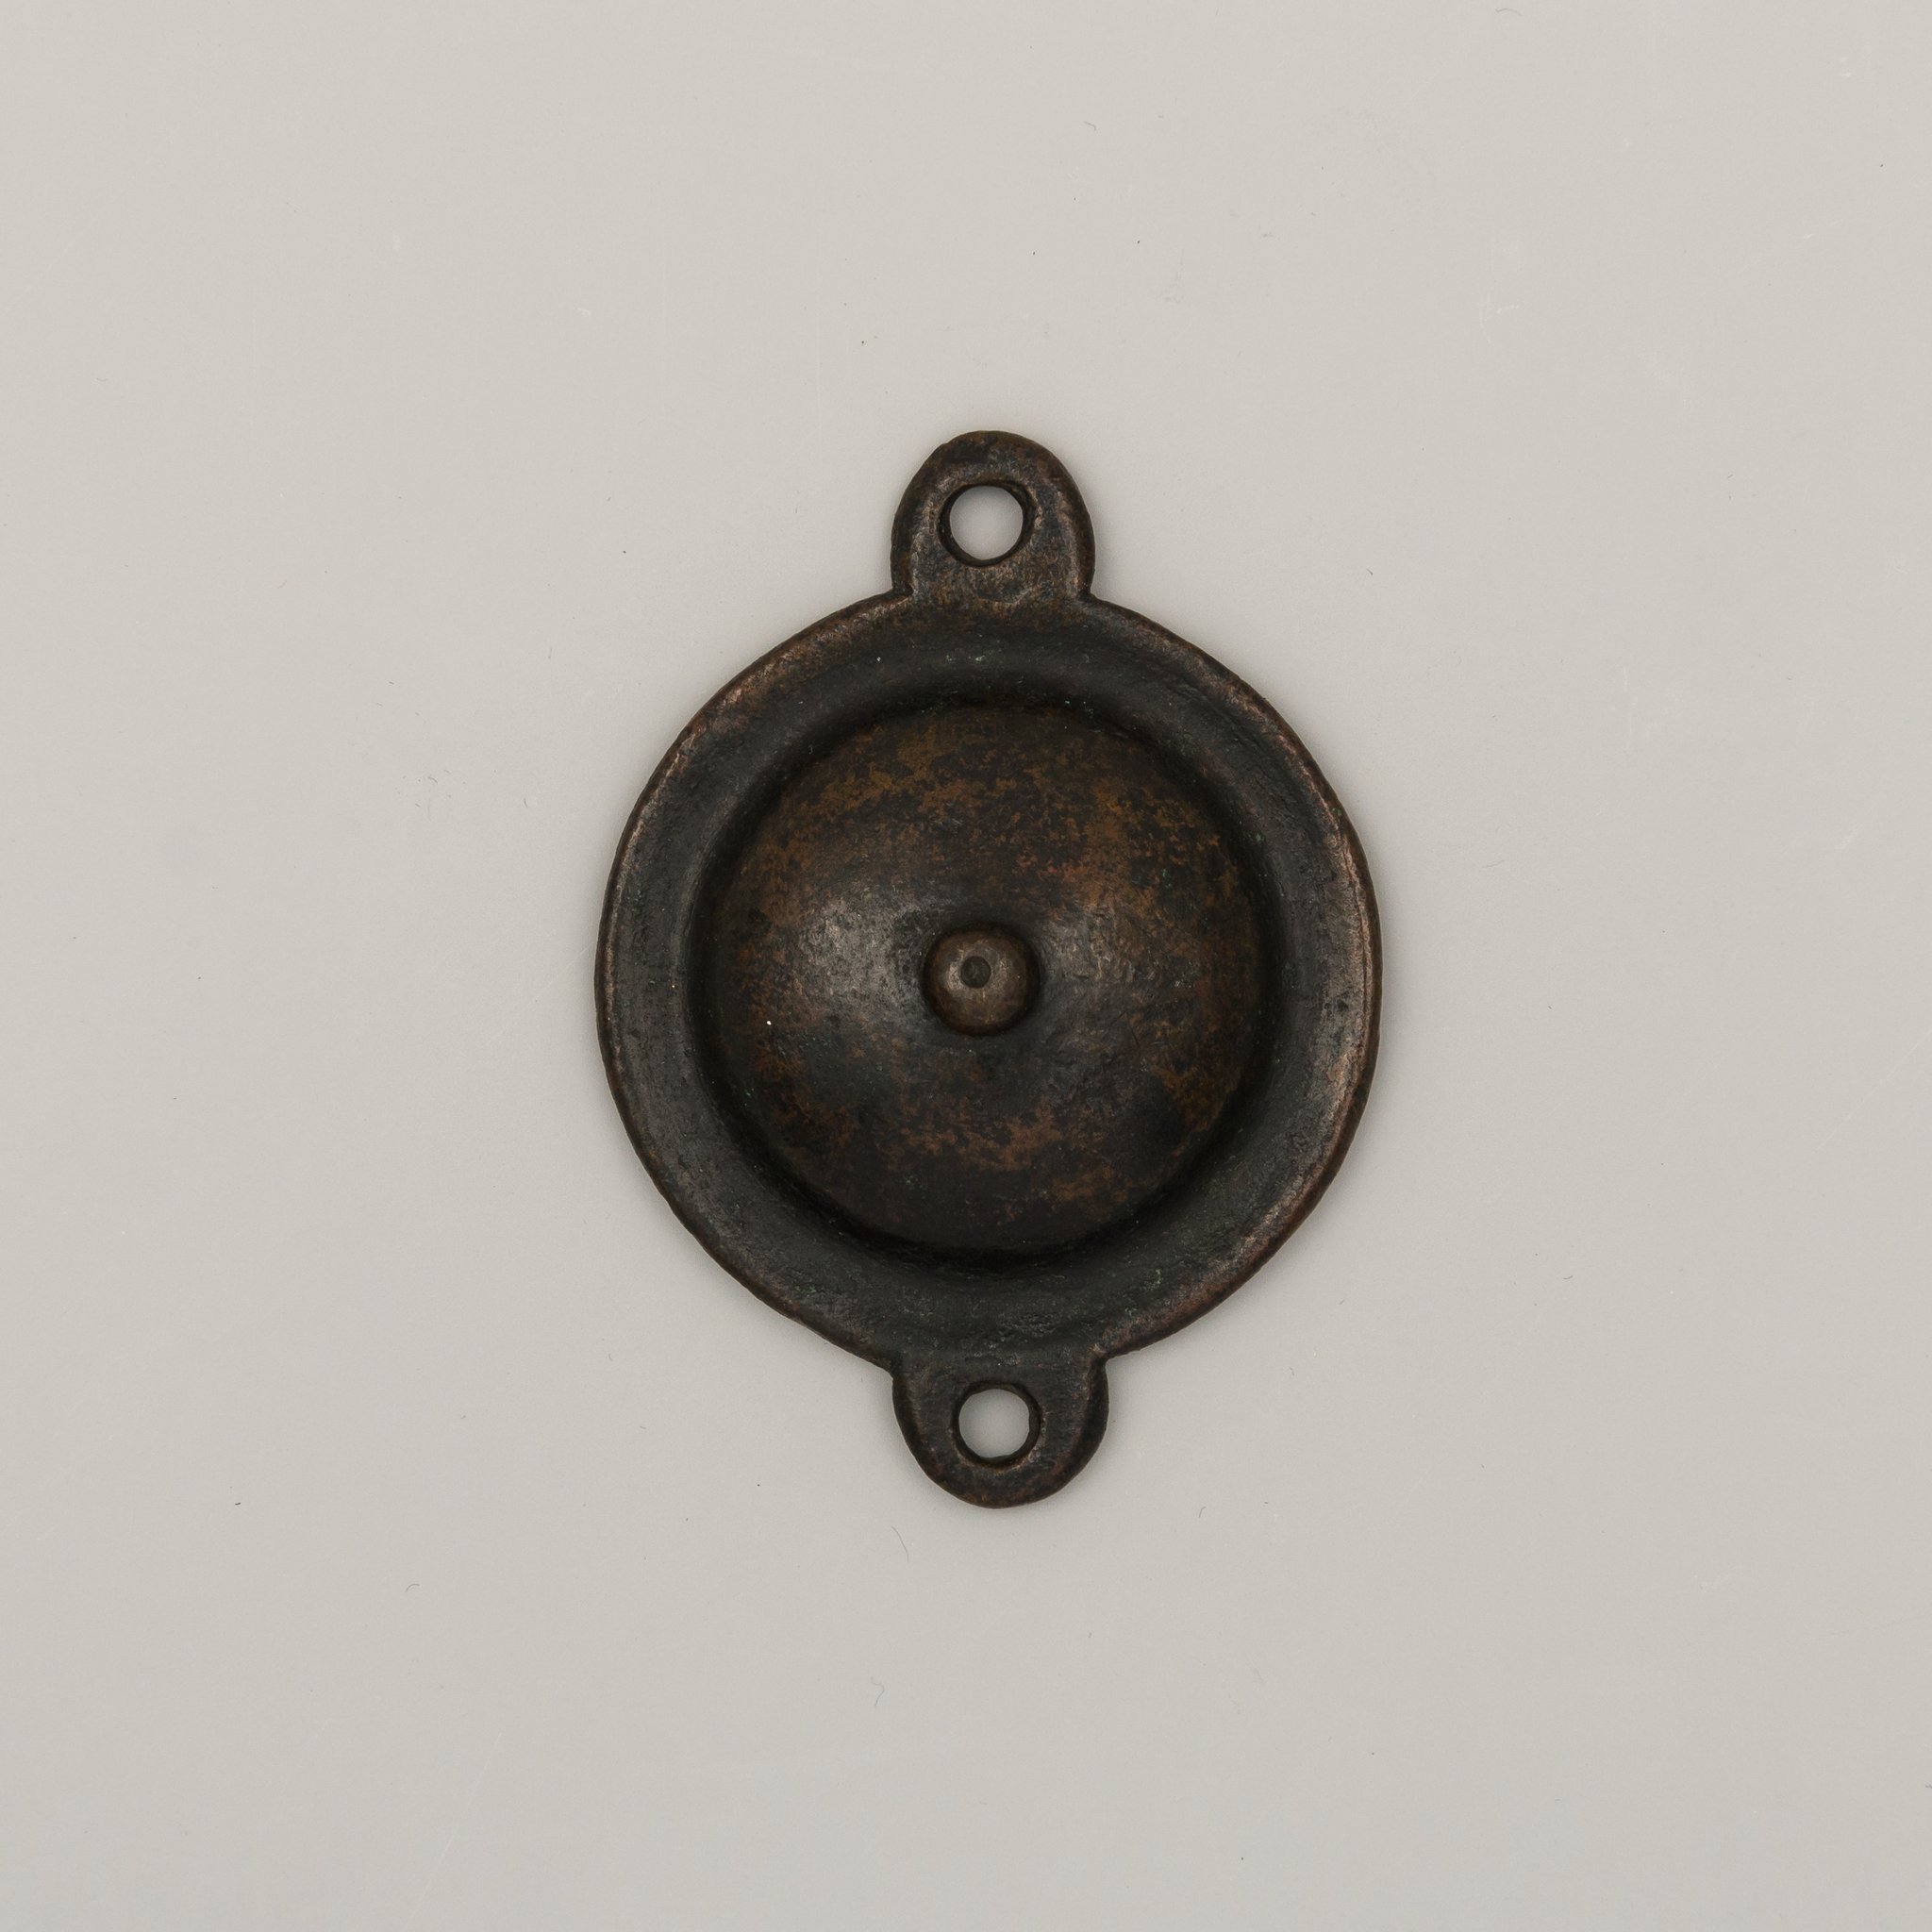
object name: bit bos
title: Bit Boss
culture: french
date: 1667-1733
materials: copper alloy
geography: france